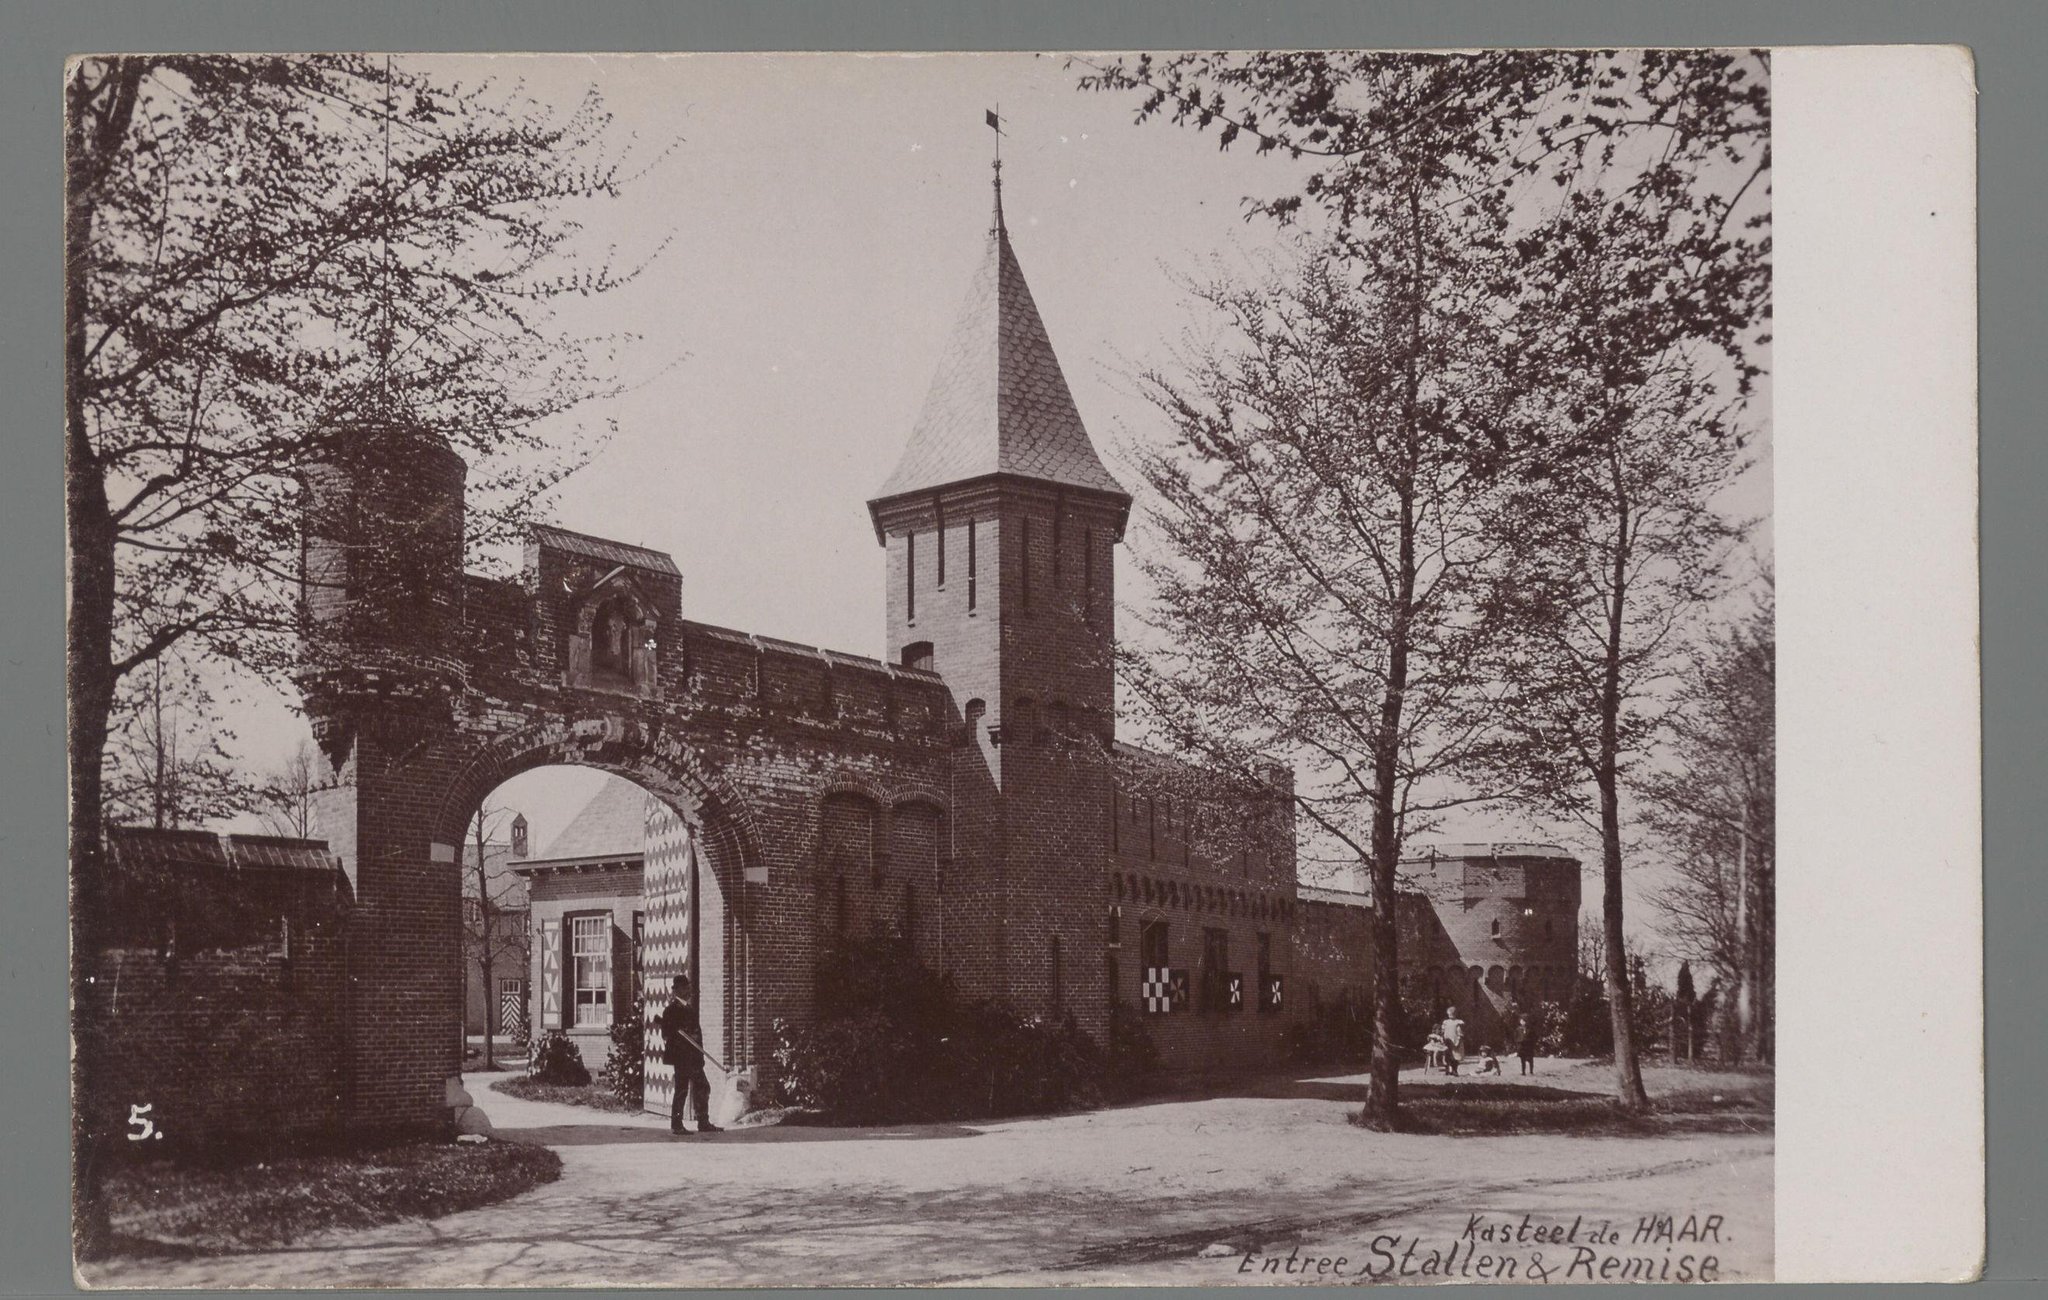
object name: photograph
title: Kasteel de Haar. Entree stallen & remise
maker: Anonymous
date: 1900-1930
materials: paper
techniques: collodion silver print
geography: haarzuilens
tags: castle, gate, entrance, stall, stable